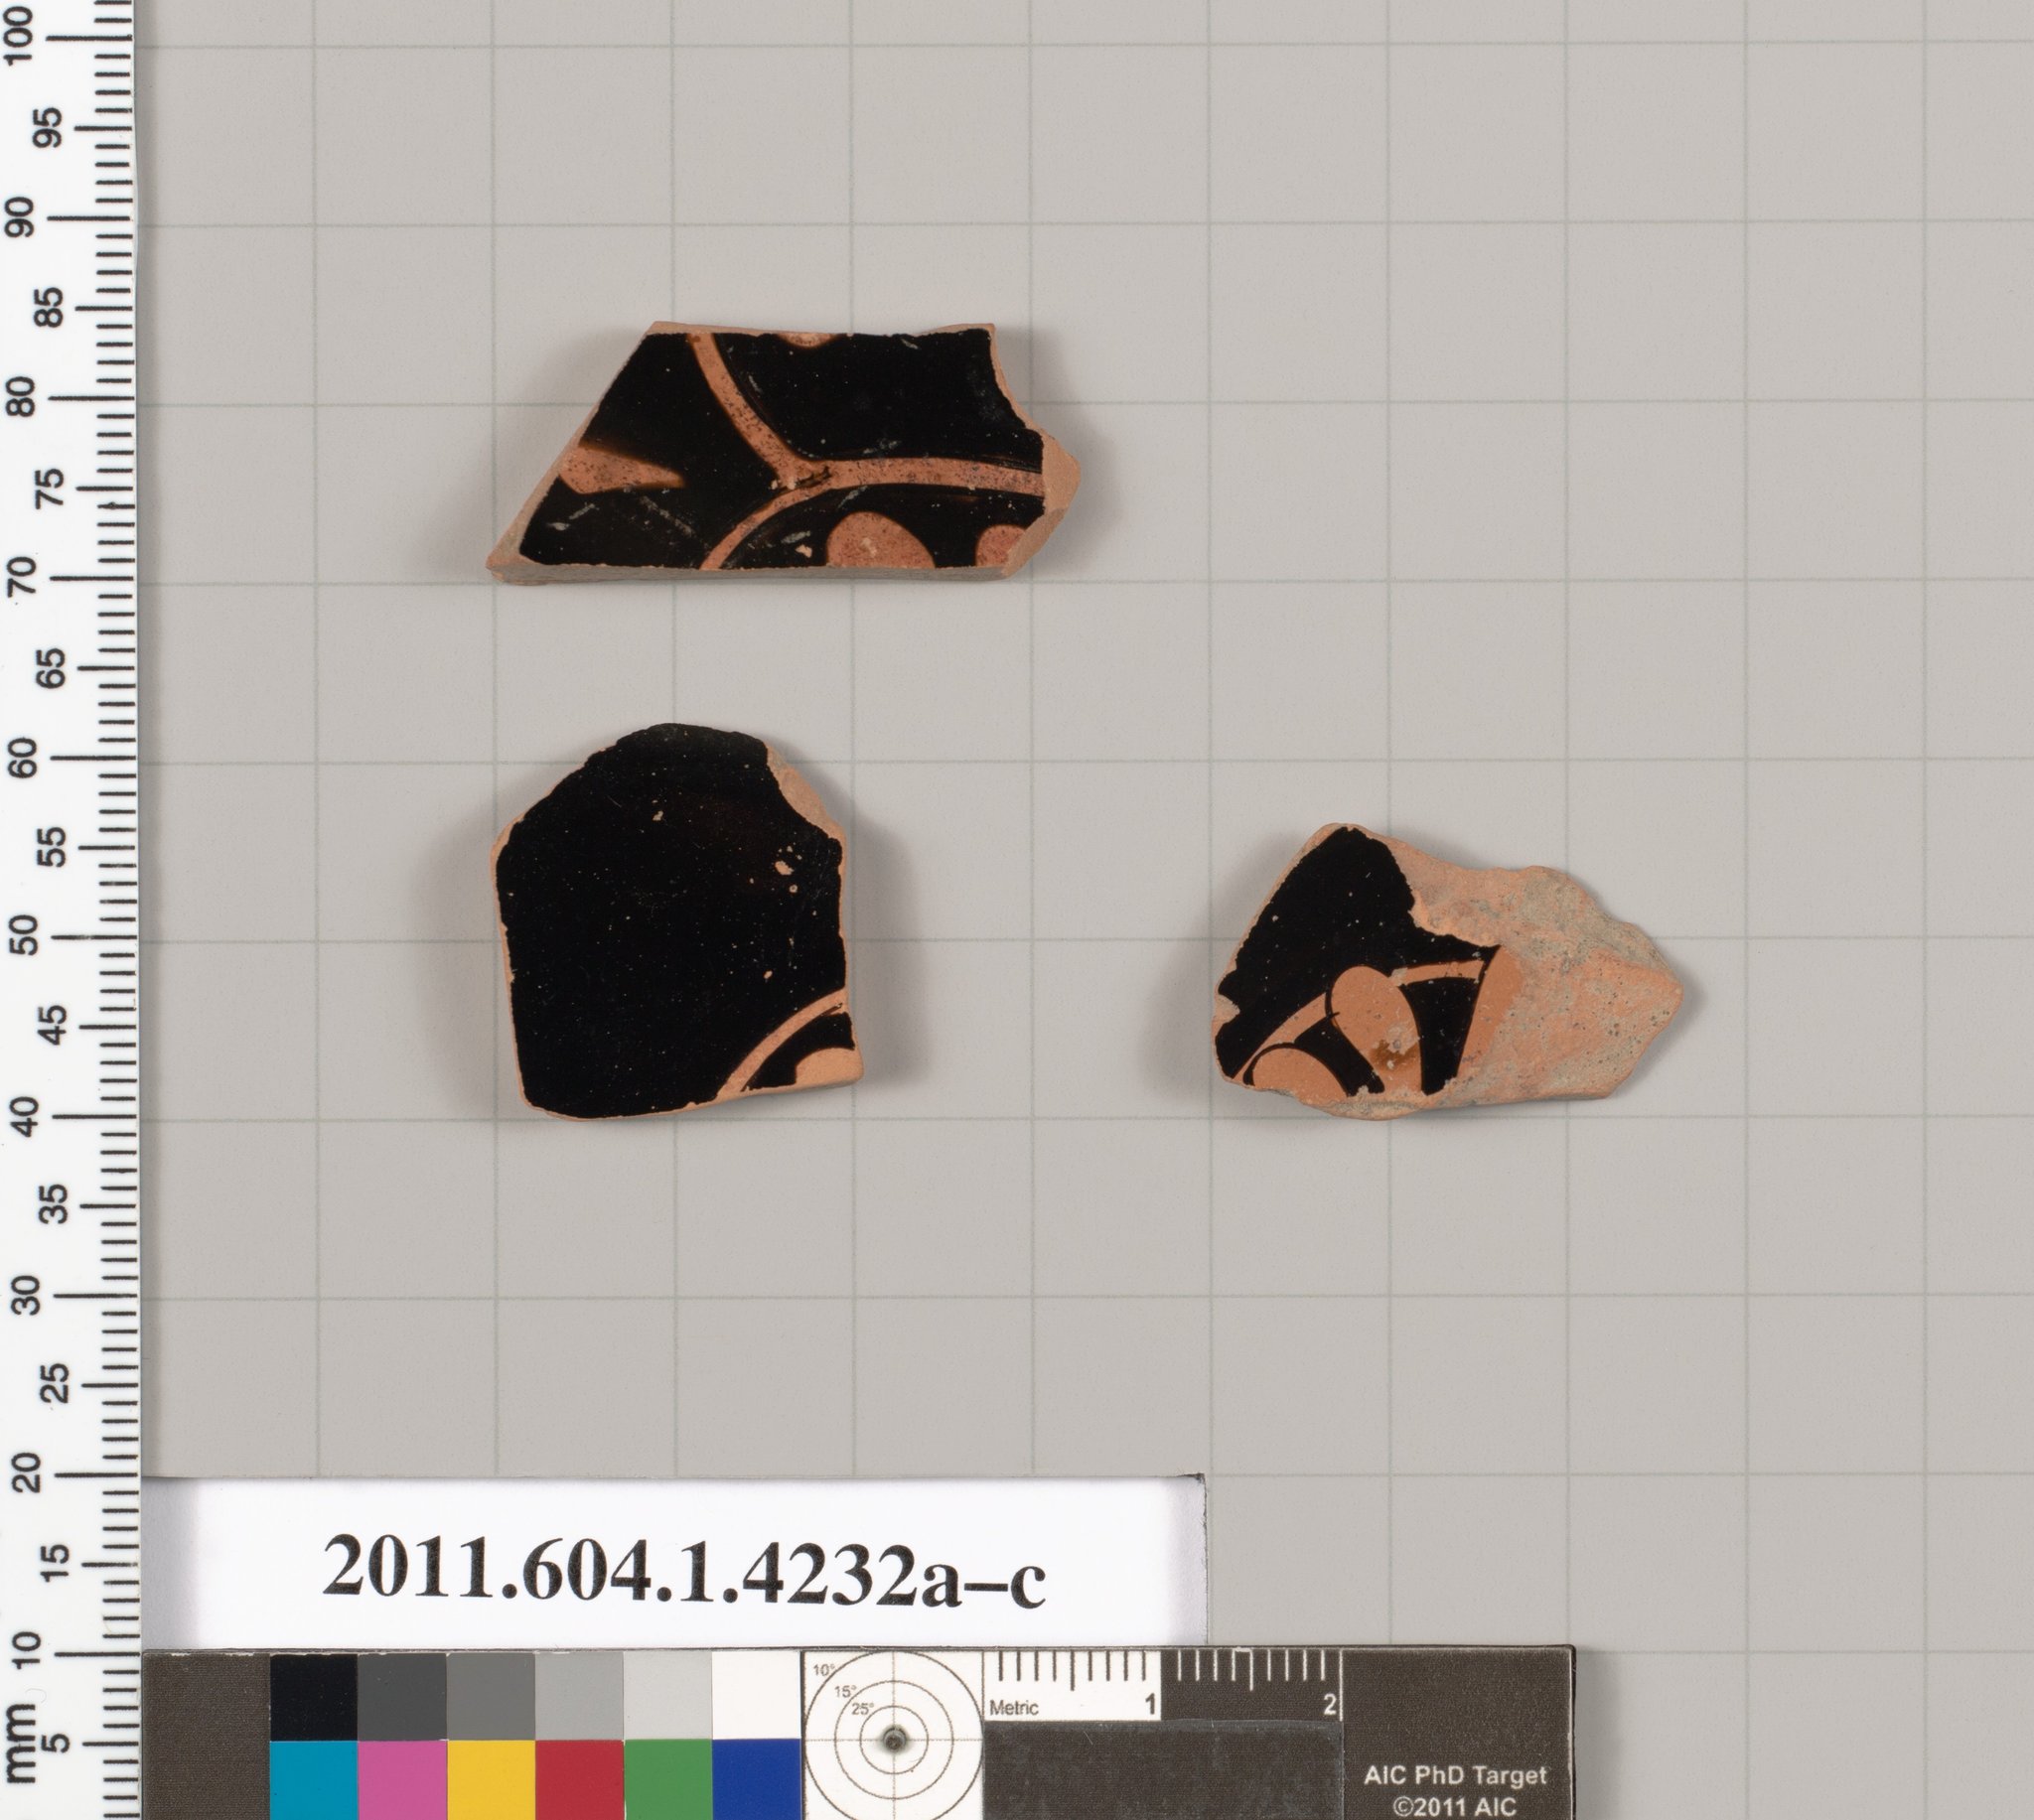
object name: kylix fragment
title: Terracotta fragments of kylikes (drinking cups)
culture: greek, attic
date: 520-500 BCE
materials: terracotta